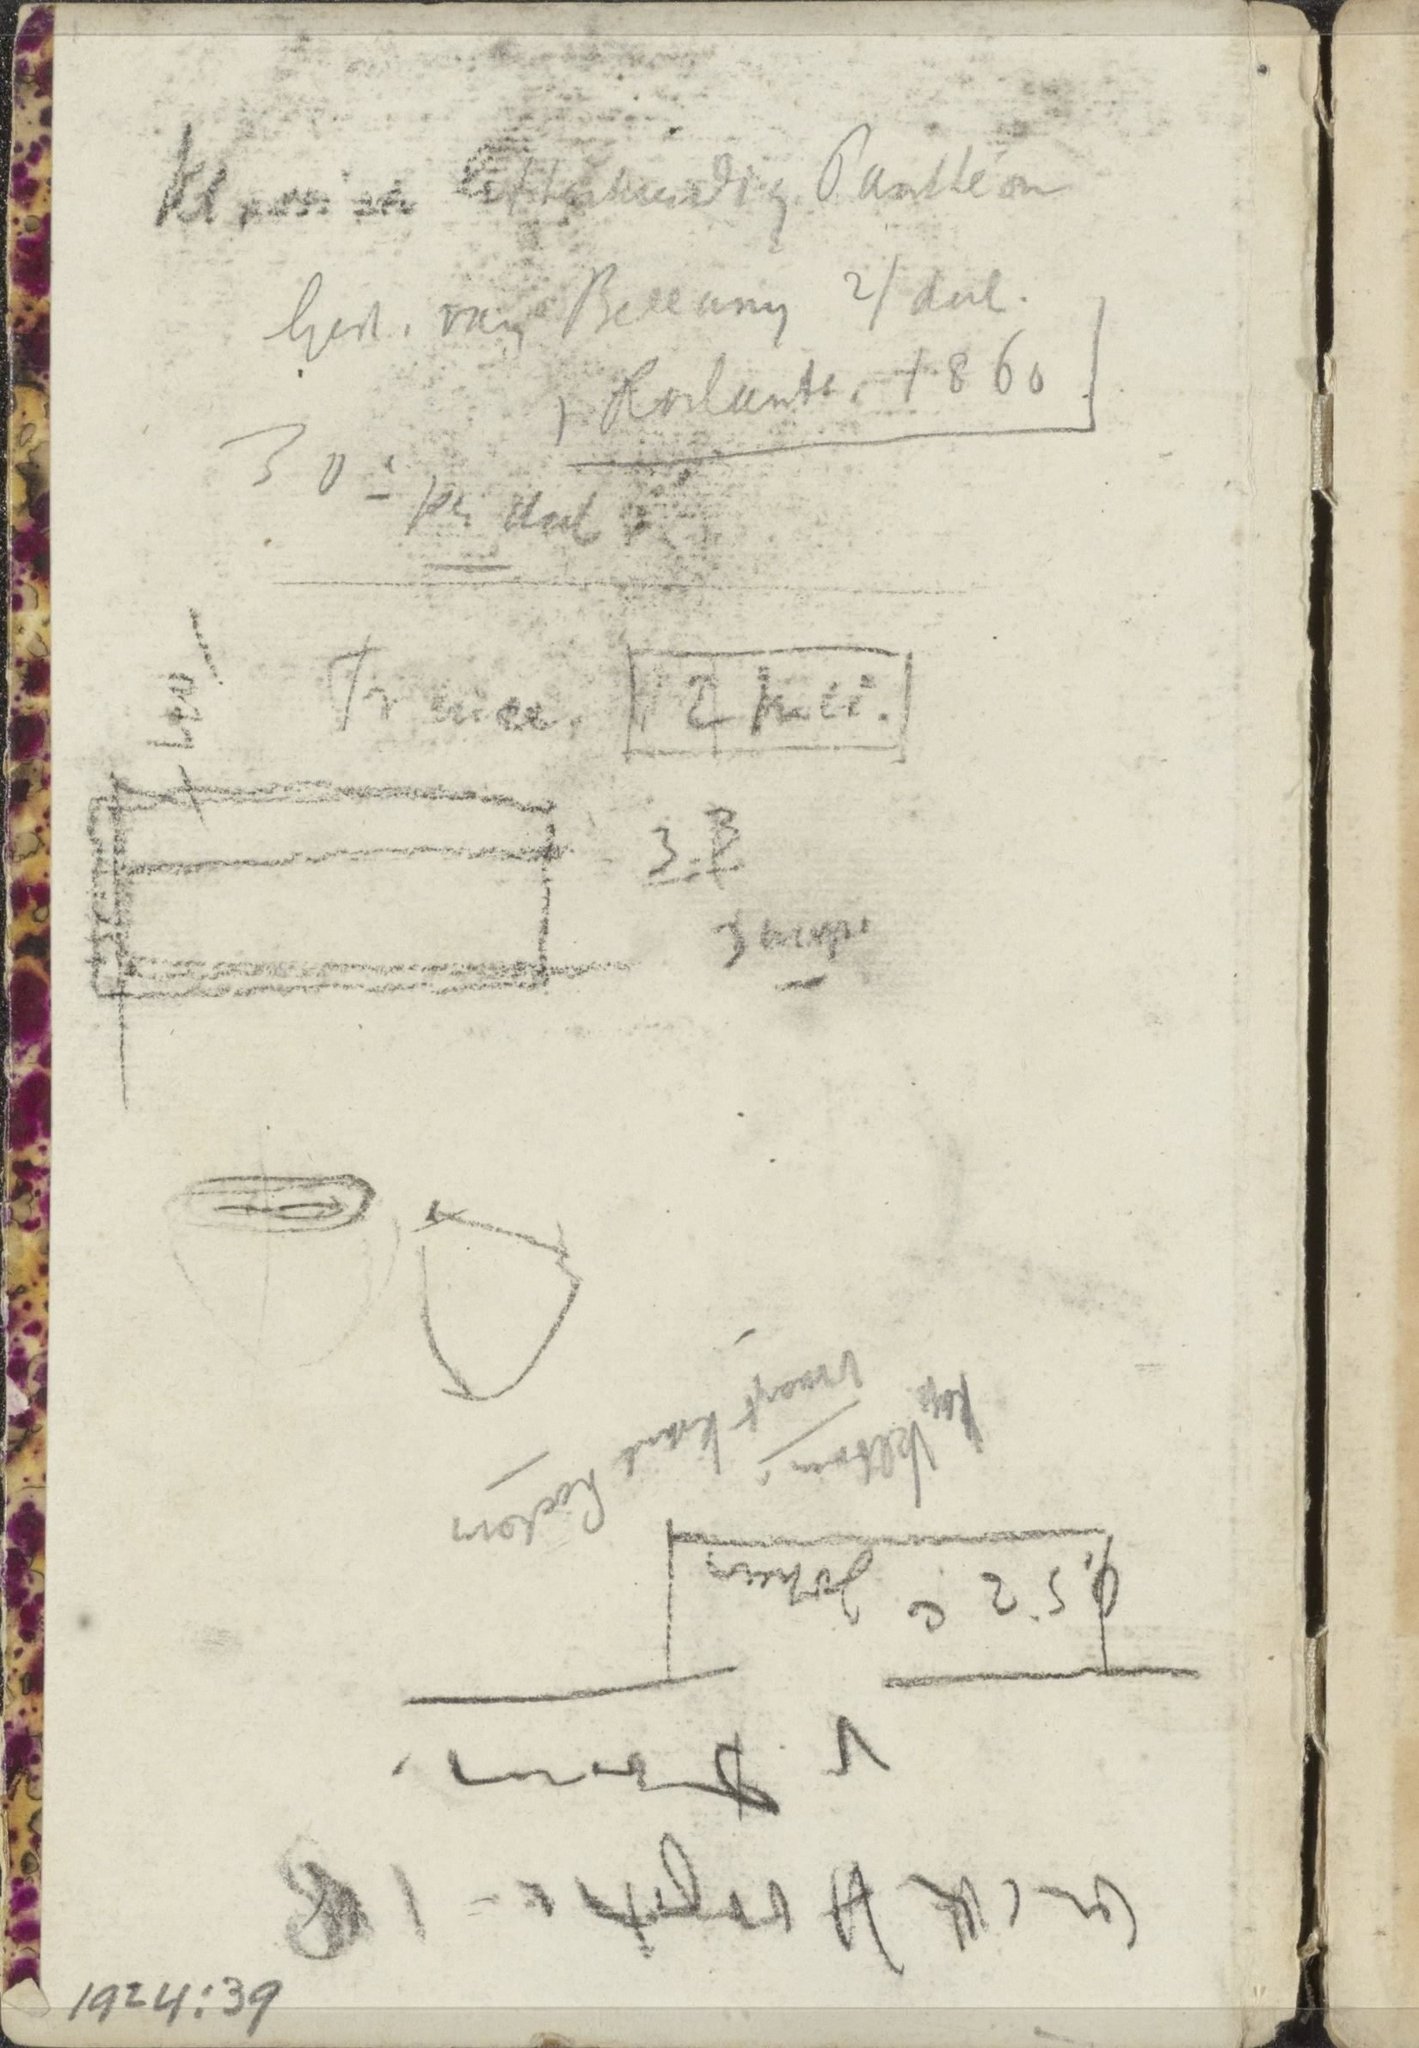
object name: endleaf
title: Studieblad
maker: george hendrik breitner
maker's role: draughtsman, painter, print maker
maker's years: 1857-1923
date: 1886-1903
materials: chalk, paper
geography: amsterdam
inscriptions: annotation: ‘Klassiek Letterkundig Panthéon/ Gest. van Bellamy 2/deel./ Roelants, 1860/ 30 per deel/ [...]/’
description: Pagina 1, voorste schutblad, uit een schetsboek met 15 bladen.